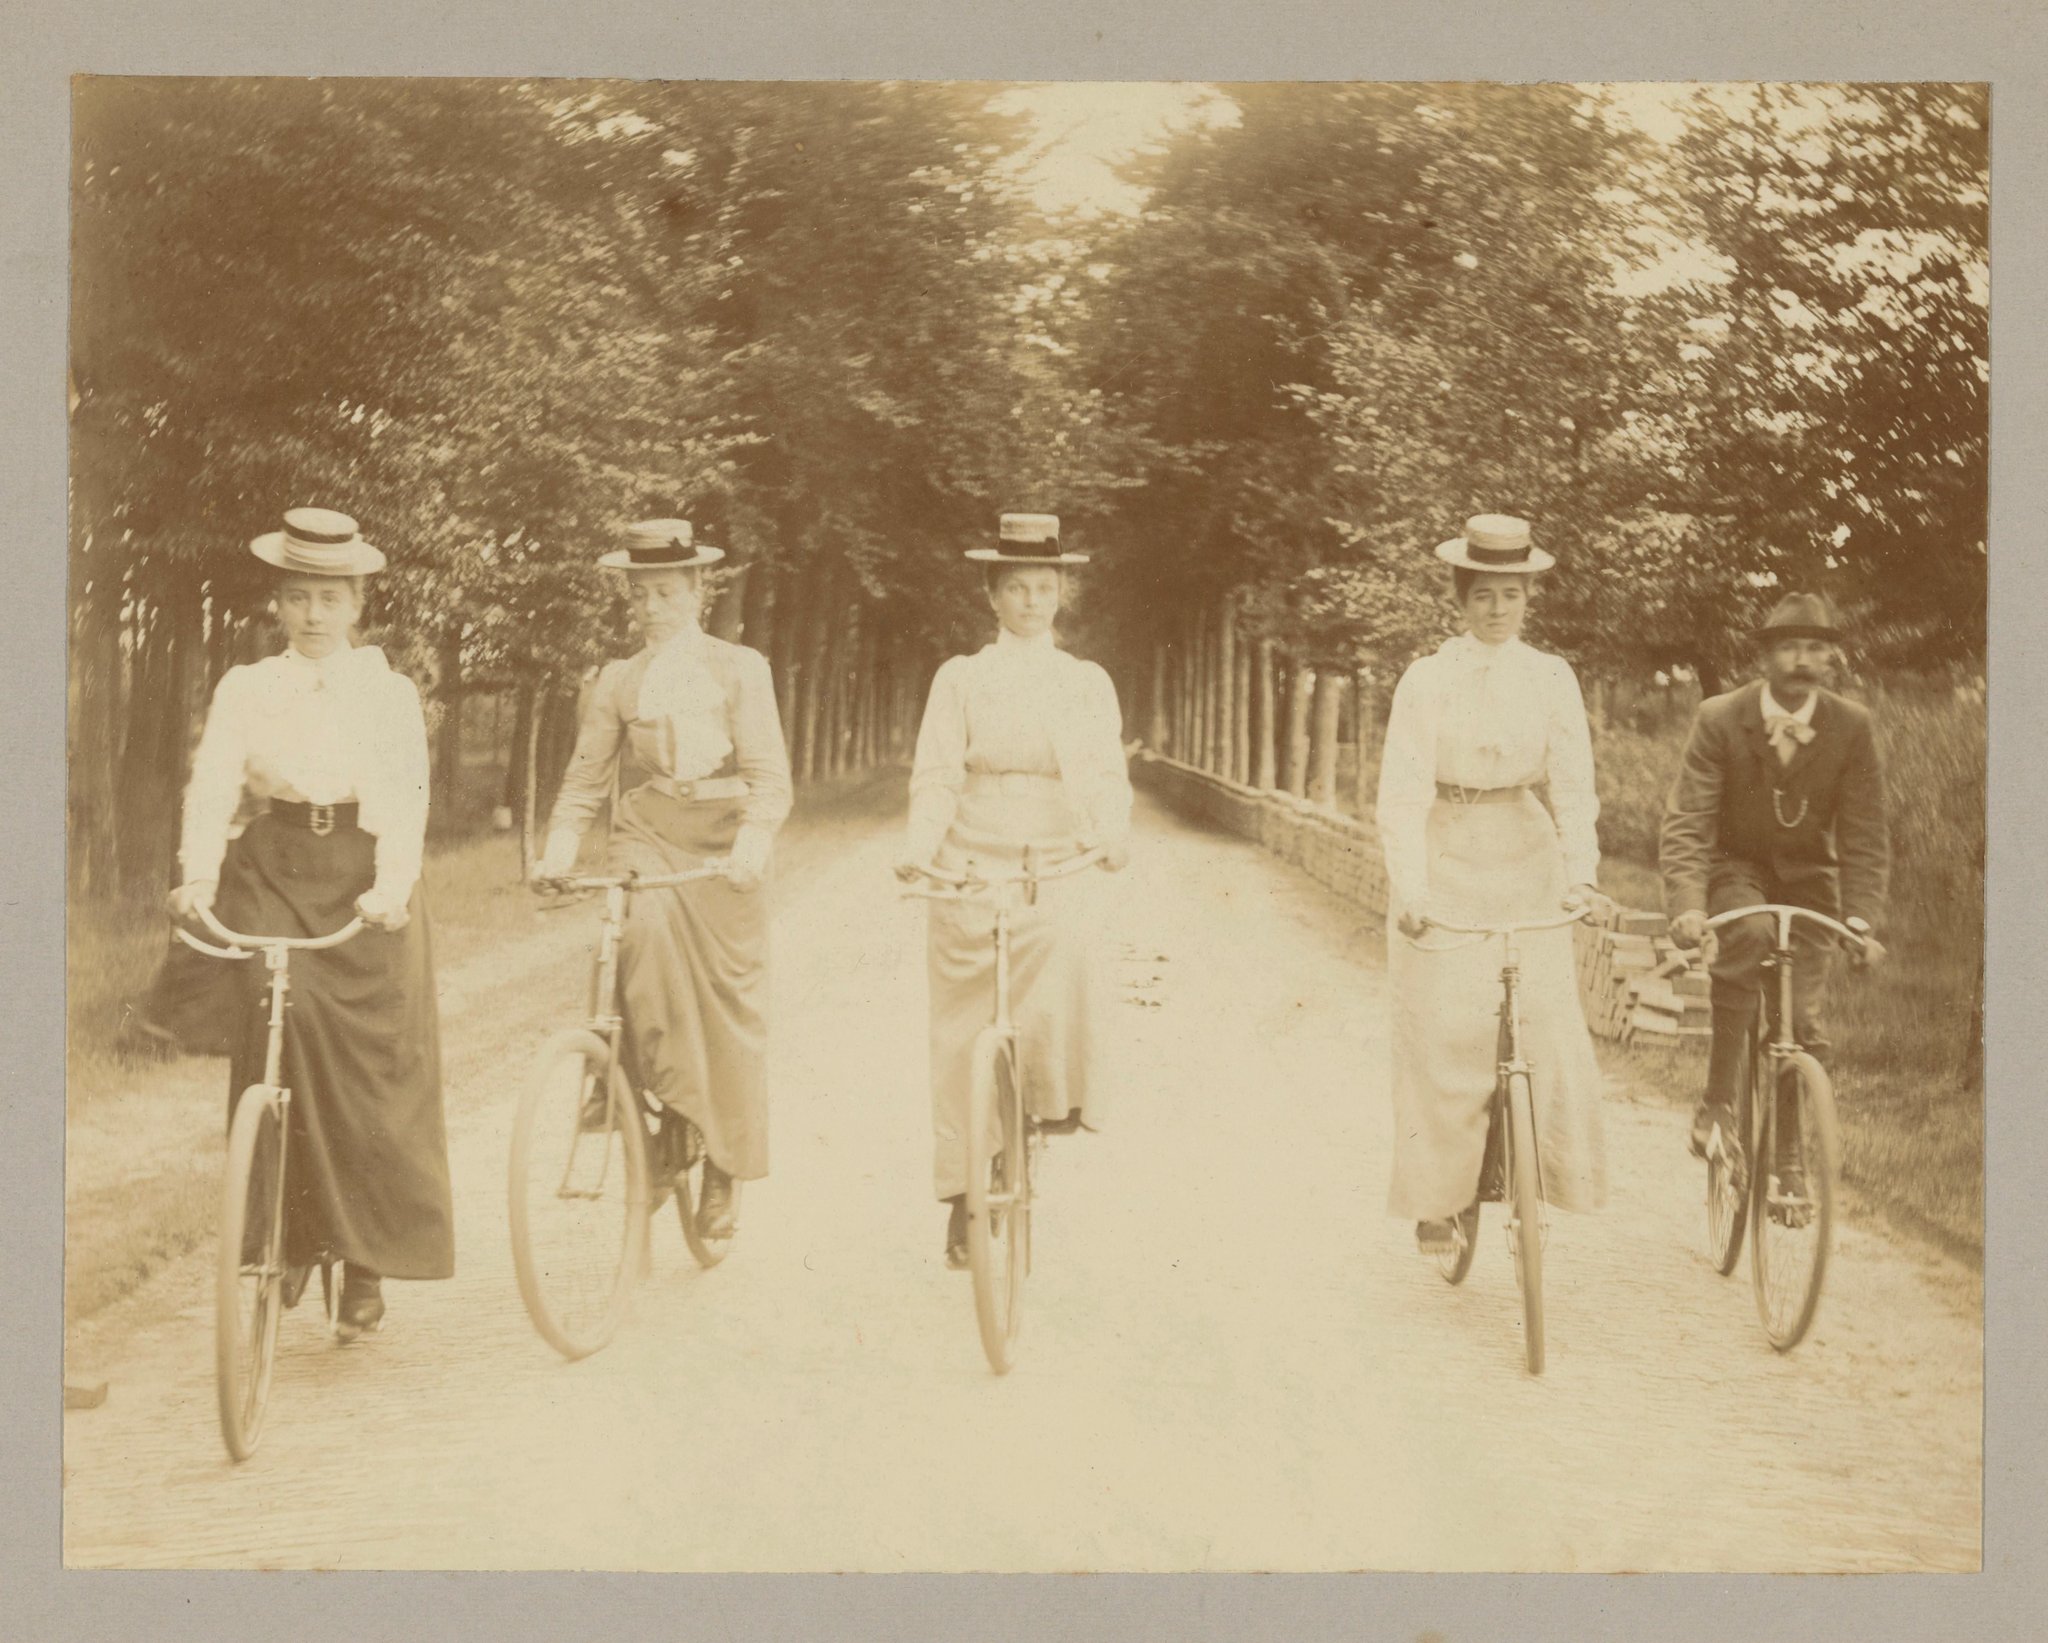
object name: photograph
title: Groepsportret van een gezelschap op de fiets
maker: cornelia hendrika jonker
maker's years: 1874-1924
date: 1880-1920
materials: cardboard, photographic support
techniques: collodion silver print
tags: bicycle, anonymous historical persons portrayed in a group, in a group-portrait